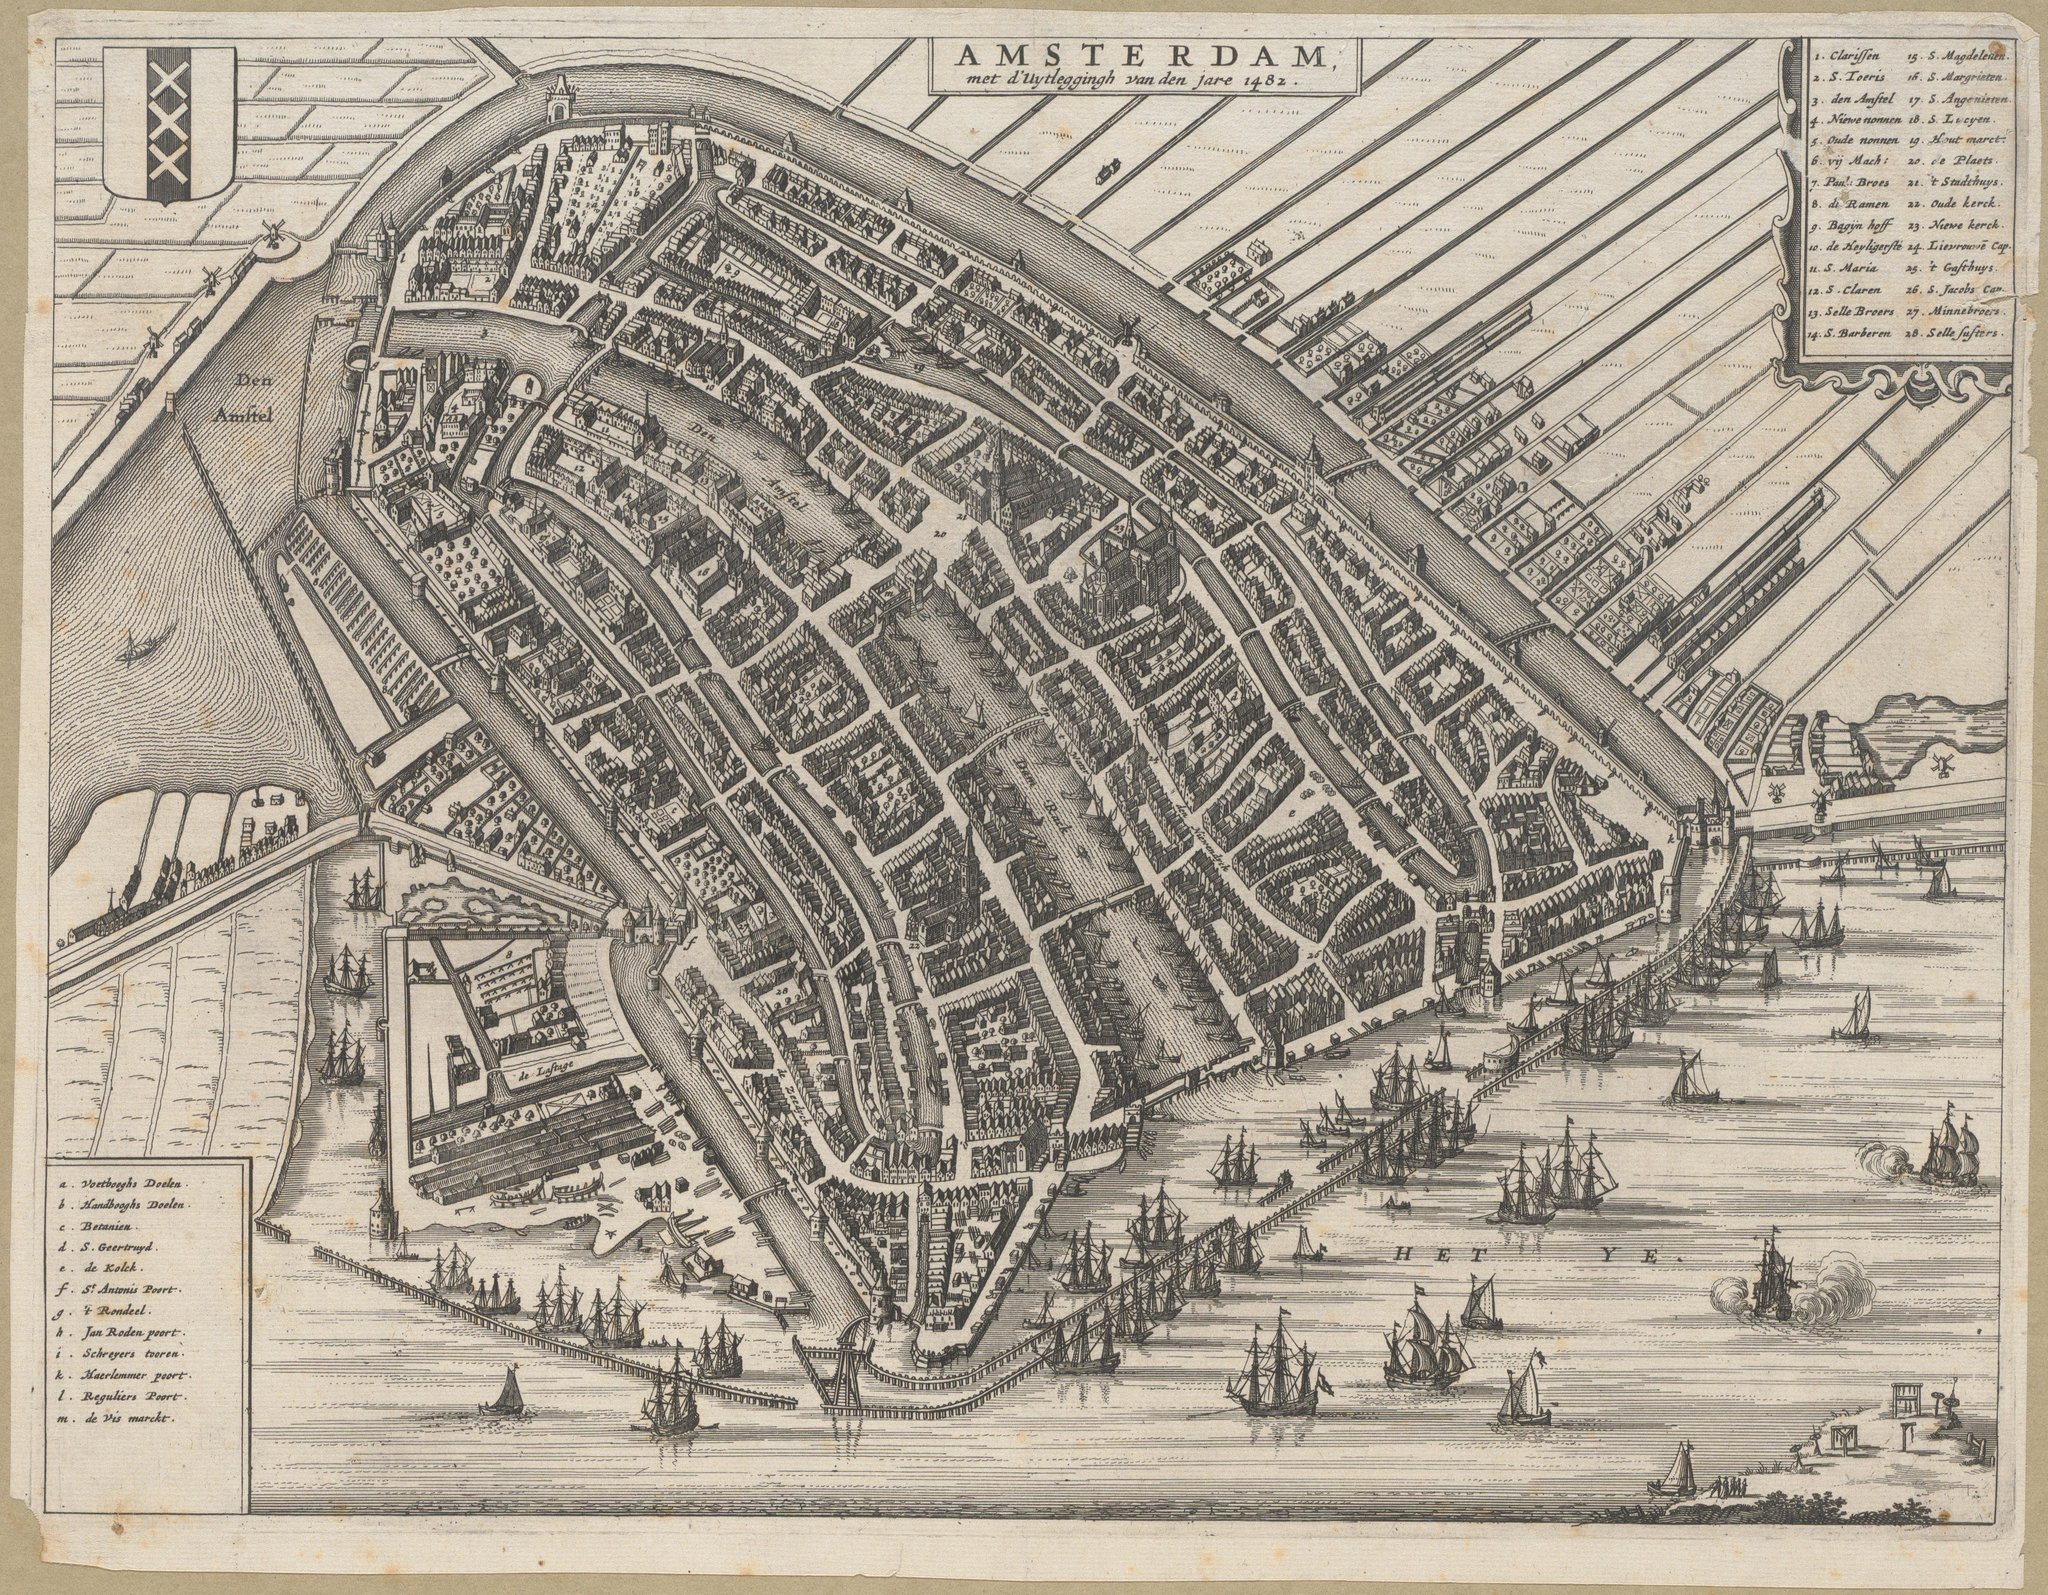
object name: print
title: Amsterdam, met d'Uytleggingh van den jare 1482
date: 1663-1664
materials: paper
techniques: engraving, etching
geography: amsterdam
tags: coat of arms (as symbol of the state, etc.) (+ city; municipal), maps of cities, amsterdam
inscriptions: collector's mark: Lugt 1641b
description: Prent mogelijk uit: Dapper, Olfert. Historische beschryving der stadt Amsterdam (…). Amsterdam: Jacob van Meurs, 1663. Of uit: Zesen, Philipp von. Beschreibung der Stadt Amsterdam (…). Amsterdam: Joachim Nosche, 1664.